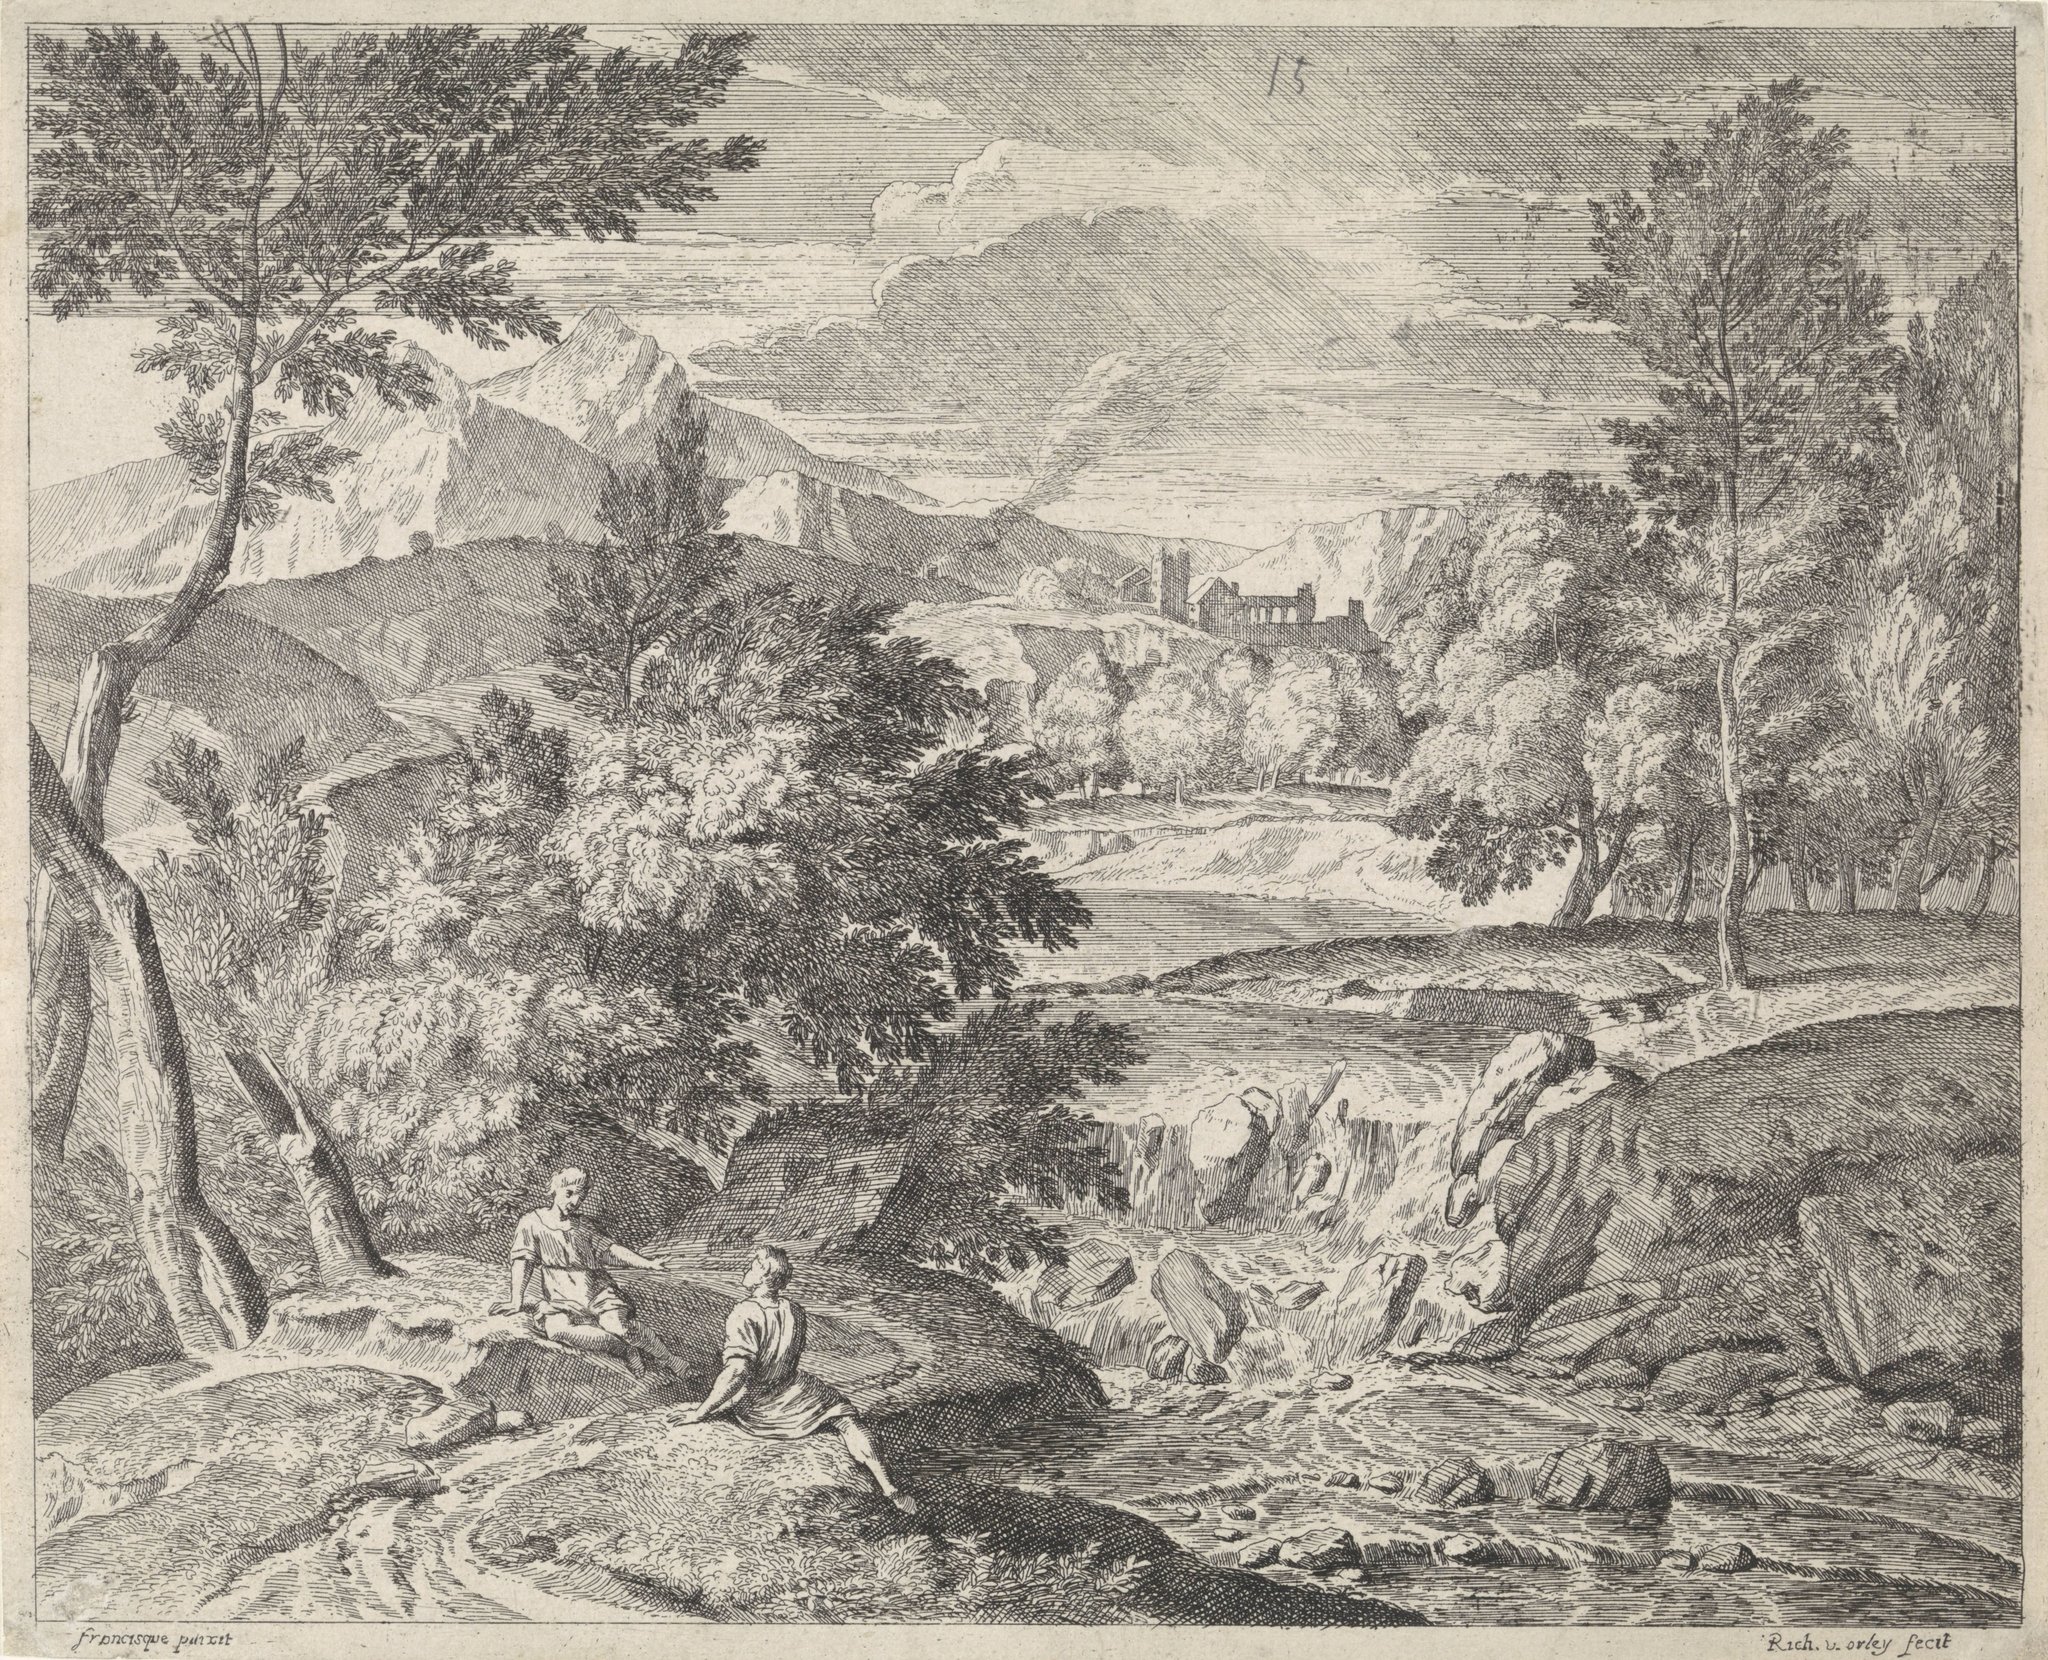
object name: print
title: Arcadisch landschap met twee figuren bij een waterval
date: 1678-1732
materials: paper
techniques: engraving, etching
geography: brussels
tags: waterfall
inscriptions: collector's mark: Lugt 2228